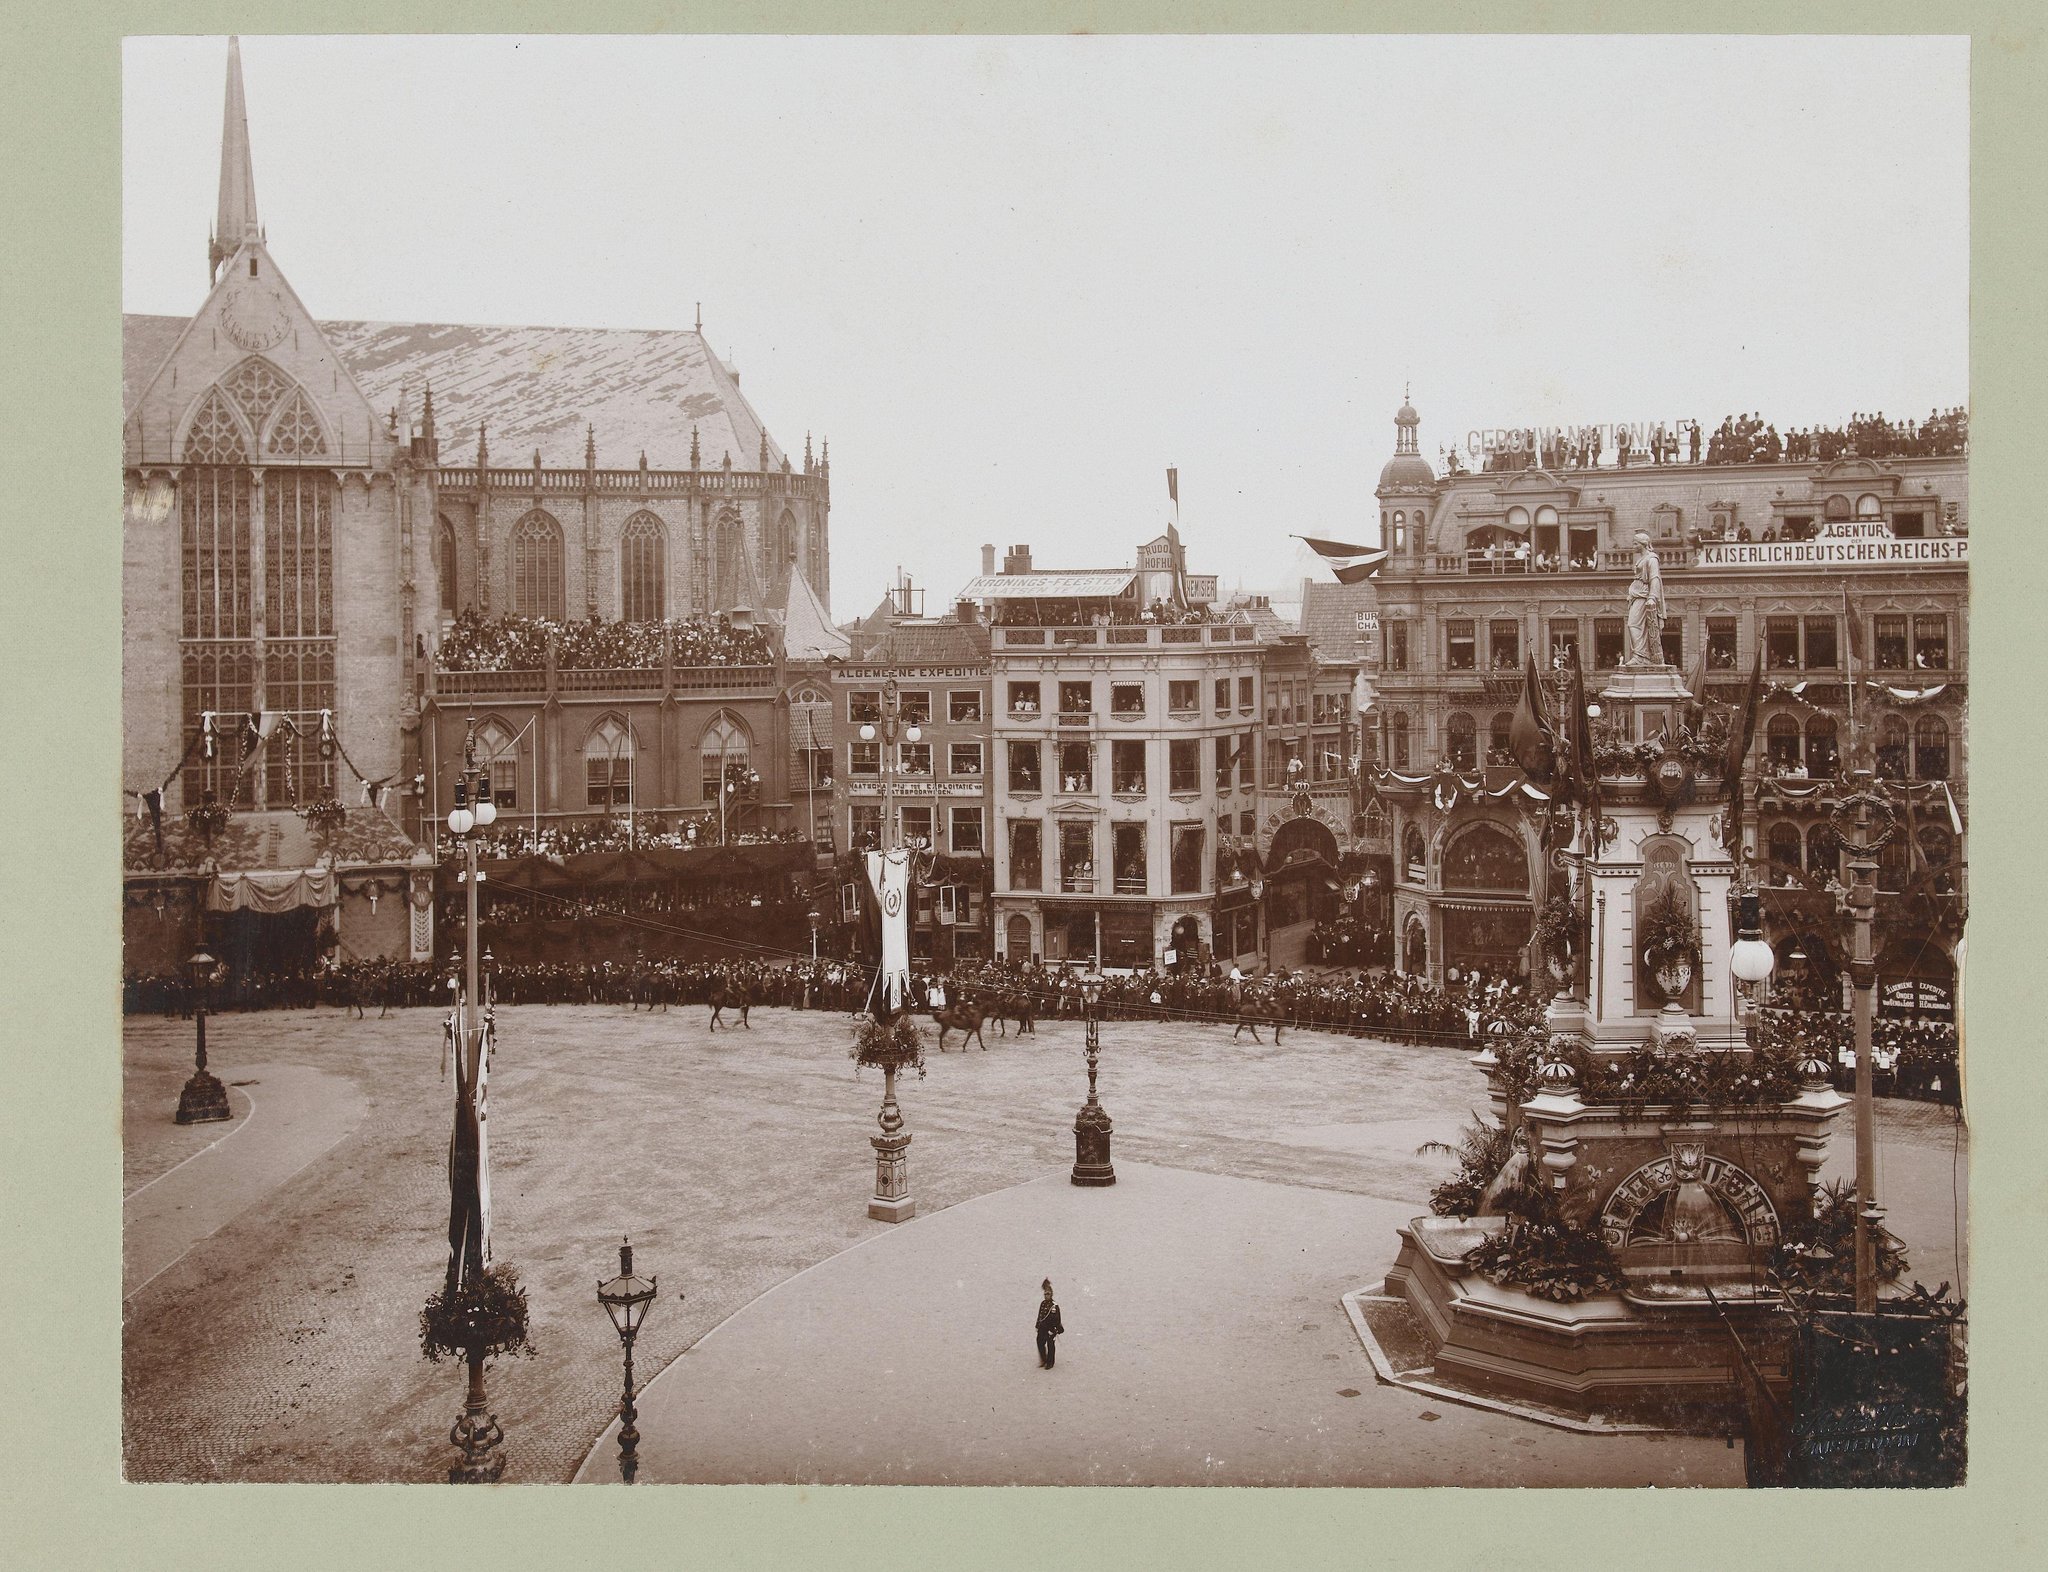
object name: photograph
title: No 9.A 5 tot 9 september 1898. Versiering van het Damplein te Amsterdam gedurende de Inhuldigingsfeesten, uitgave HERZ Amsterdam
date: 1898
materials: paper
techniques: collodion silver print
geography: amsterdam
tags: the hague, wilhelmina of the netherlands, square, place, circus, etc., amsterdam